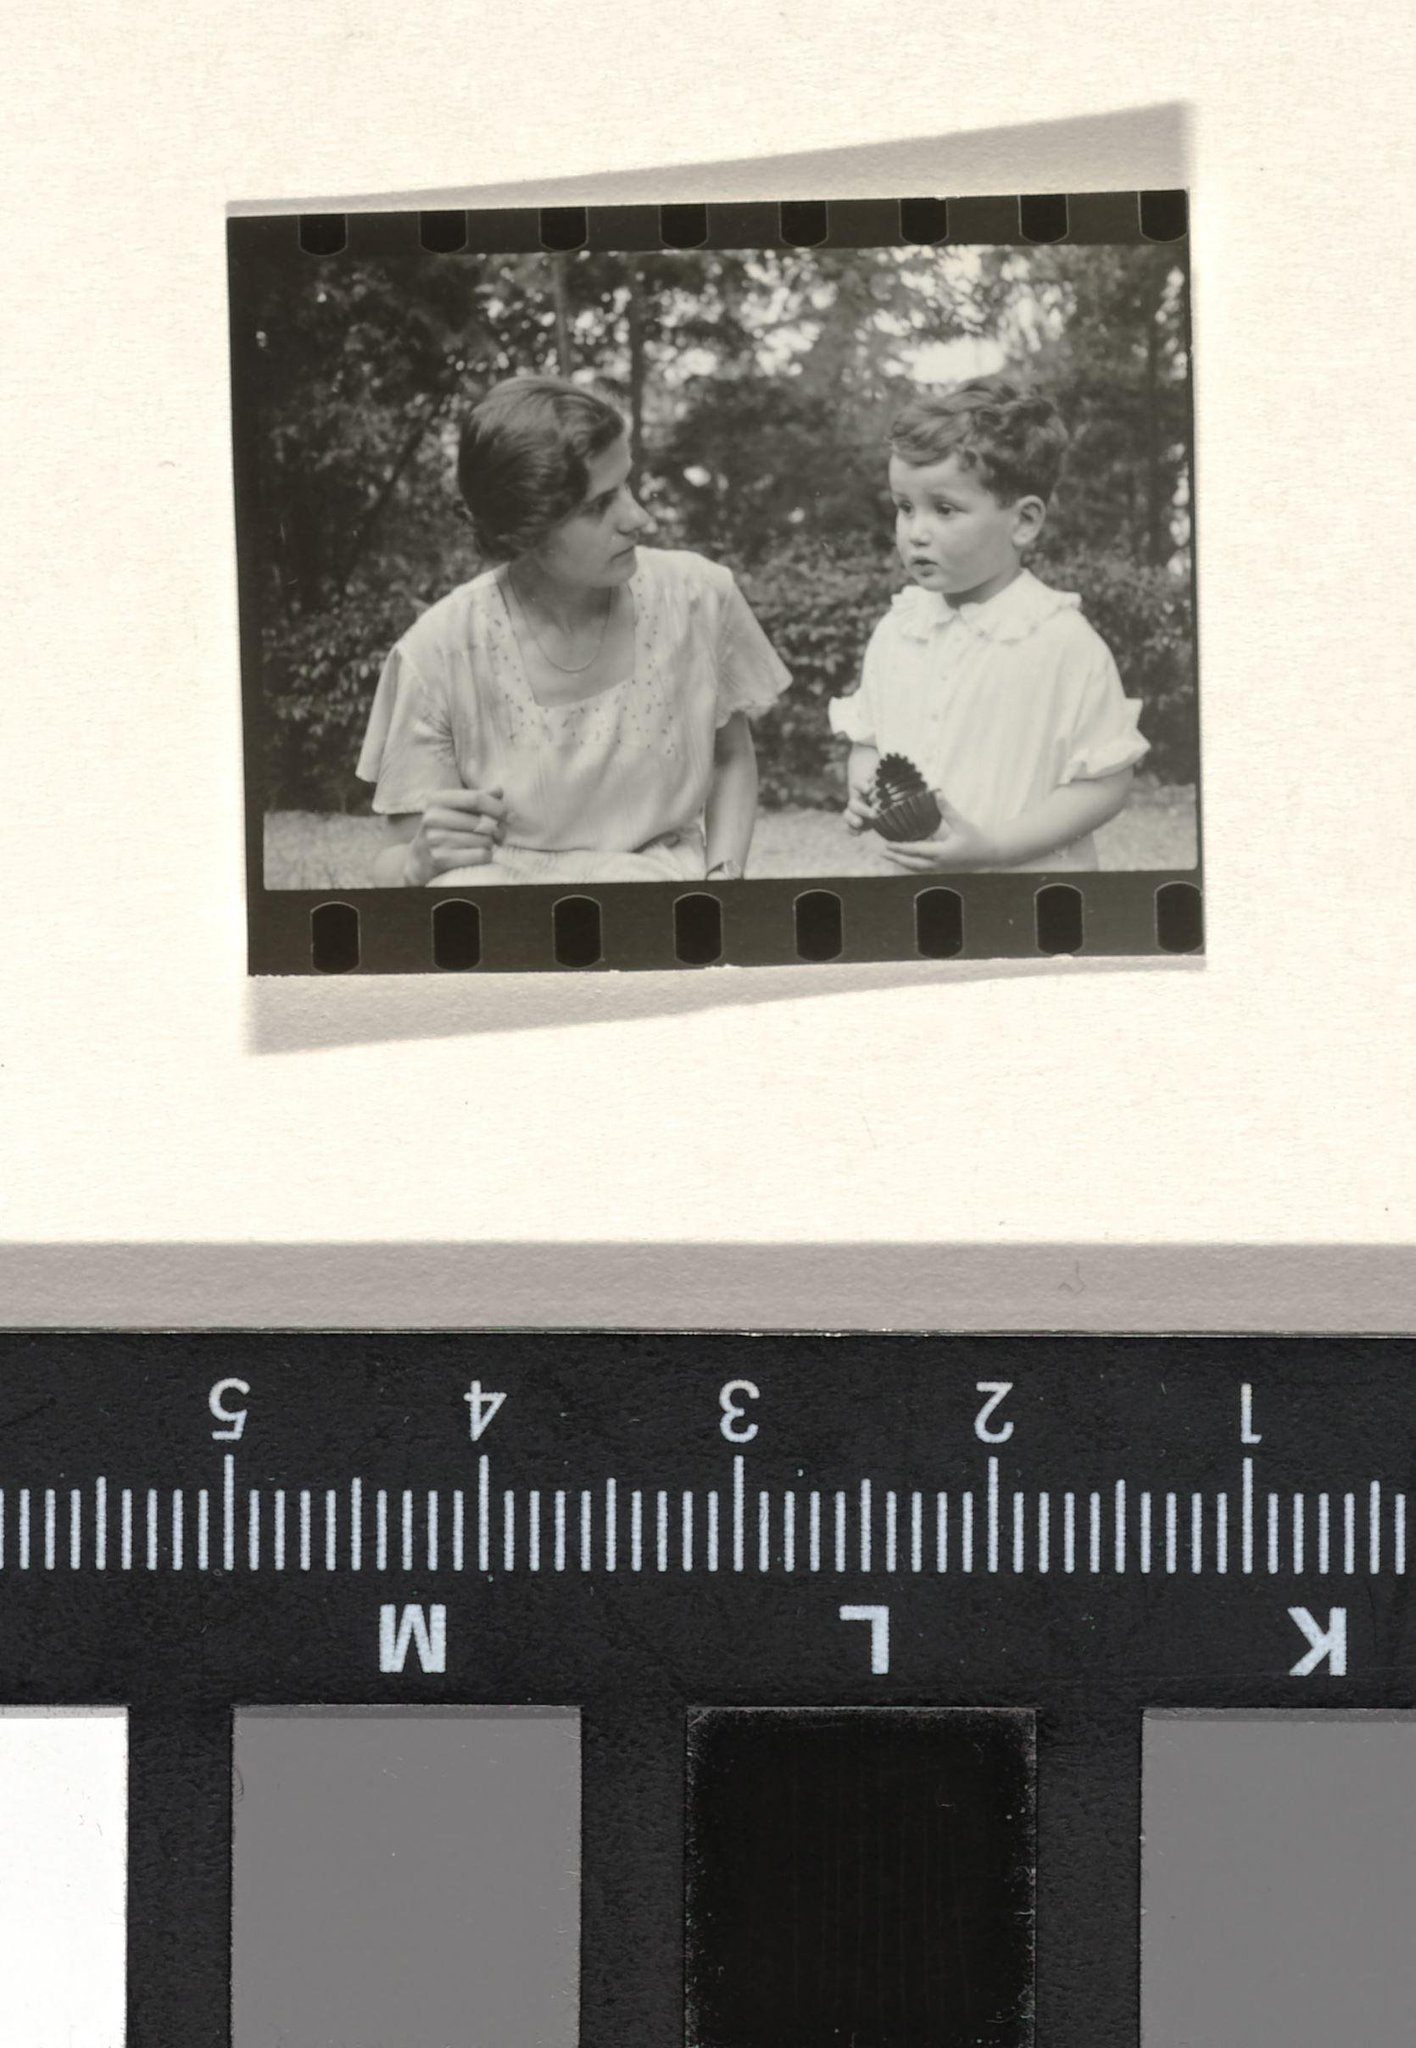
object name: photograph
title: Lid van de huishoudelijke staf van de familie Wachenheimer, vermoedelijk het kindermeisje, met een onbekend kind, op een gazon met begroeiing op de achtergrond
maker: Anonymous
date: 1928-1937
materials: photographic support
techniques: gelatin silver print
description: Onbekend lid van de huishoudelijke staf van de familie Wachenheimer (links) met een onbekend kind (rechts), op een gazon met begroeiing op de achtergrond.